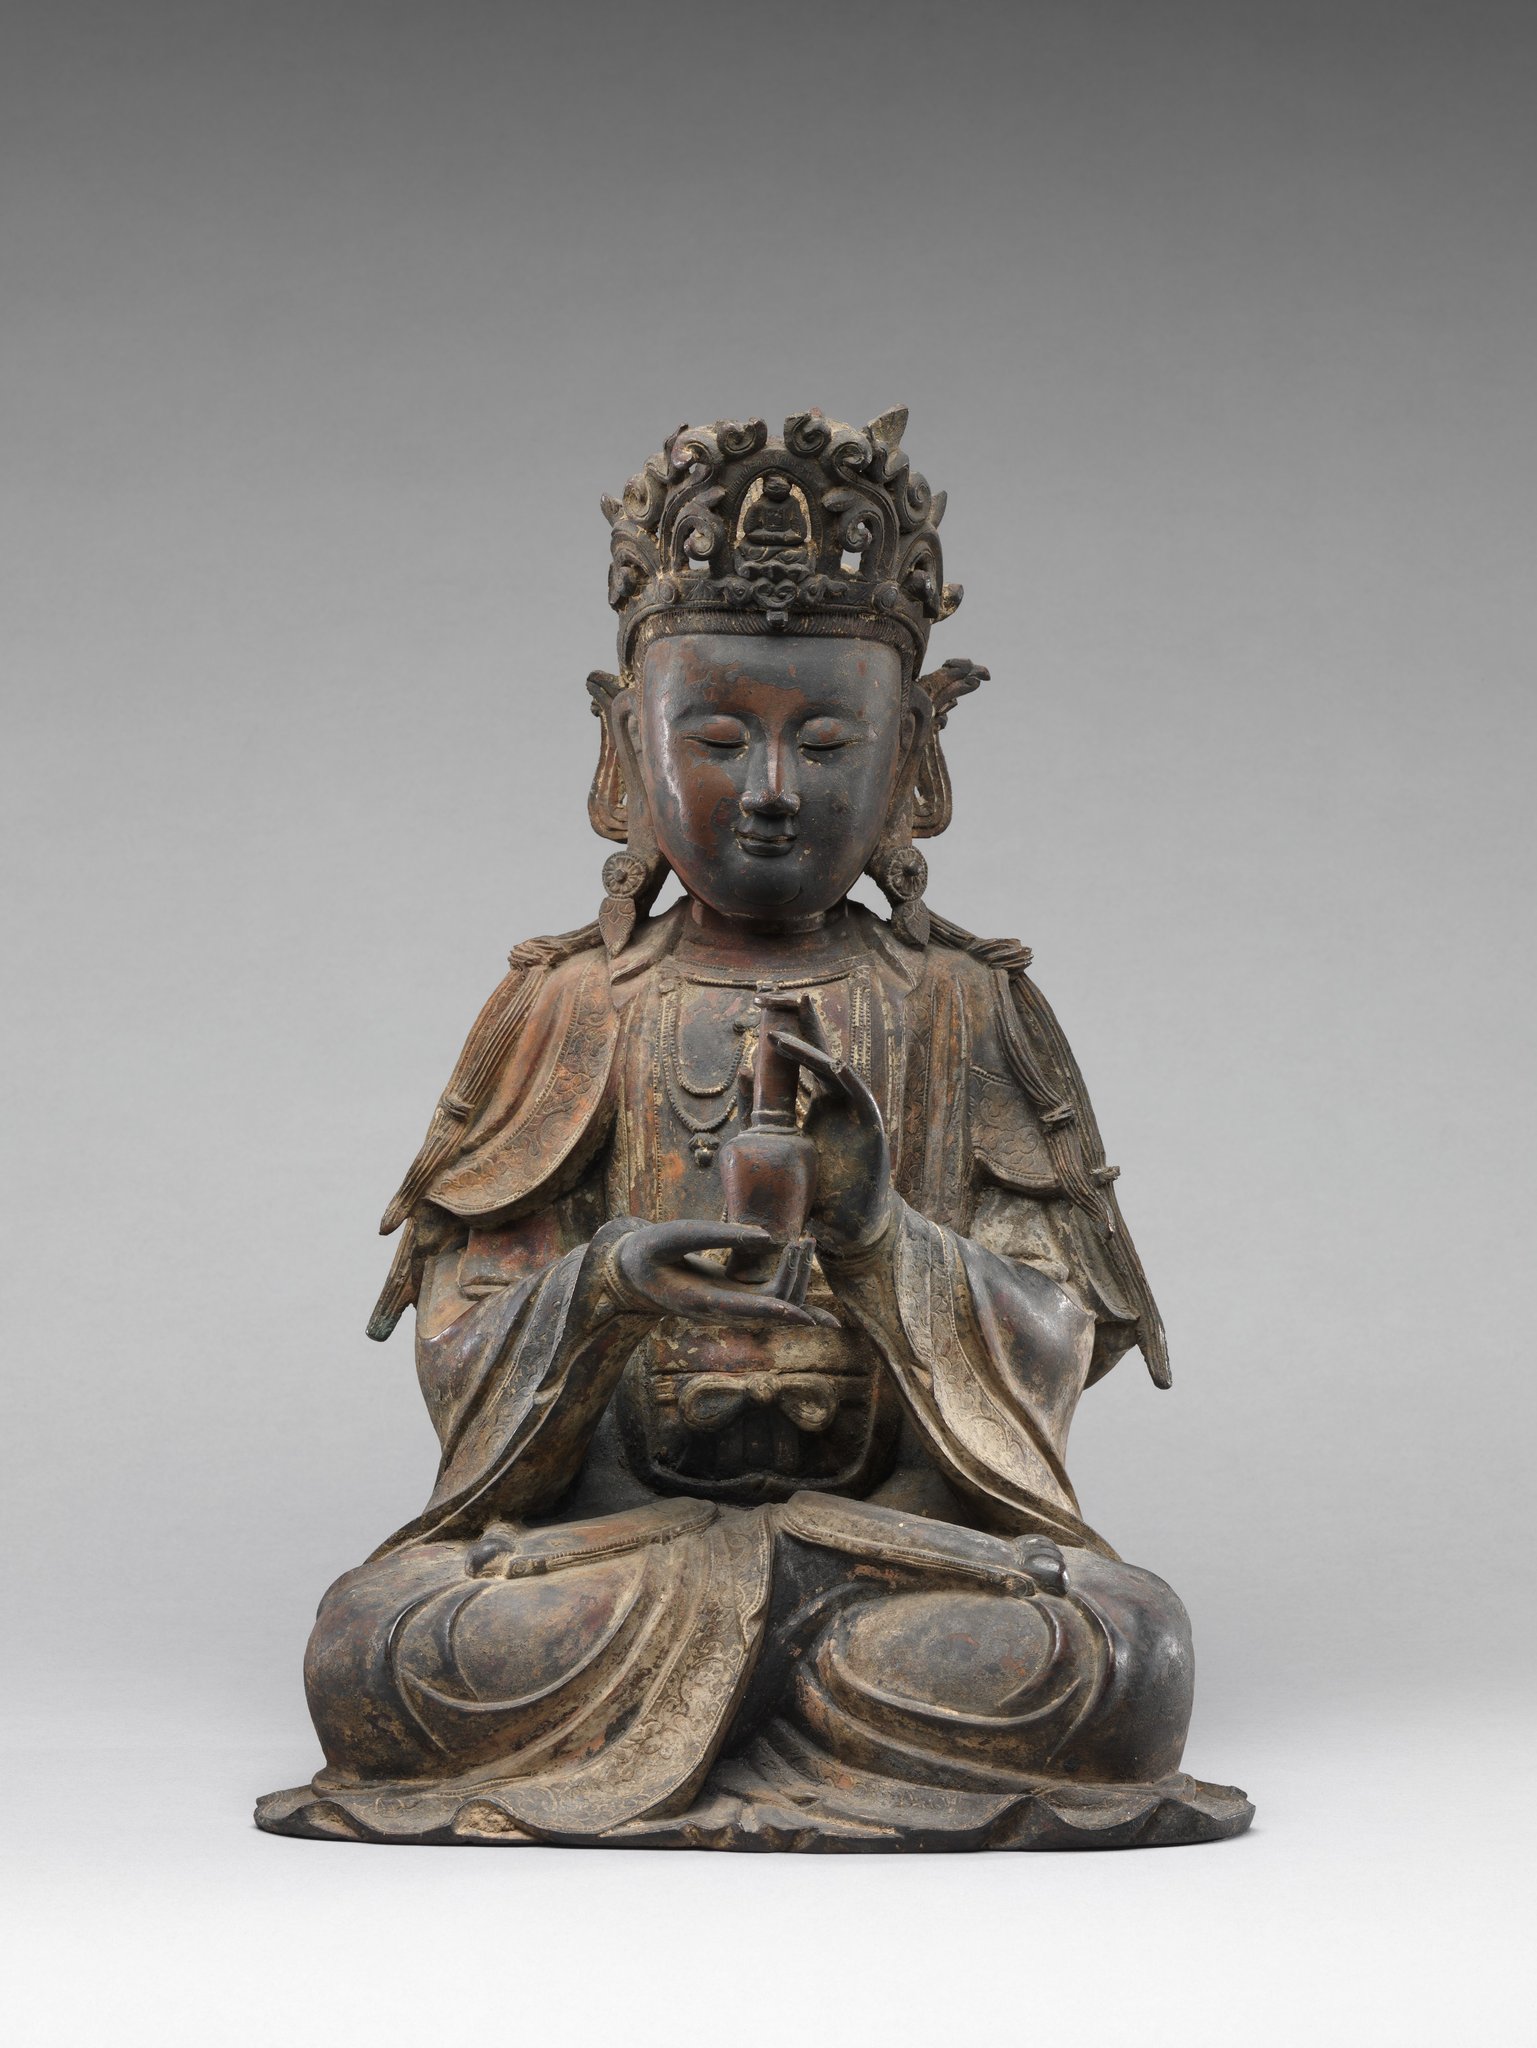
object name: figure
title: Bodhisattva Guanyin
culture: chinese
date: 1401-1600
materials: brass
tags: buddhism,avalokiteshvara